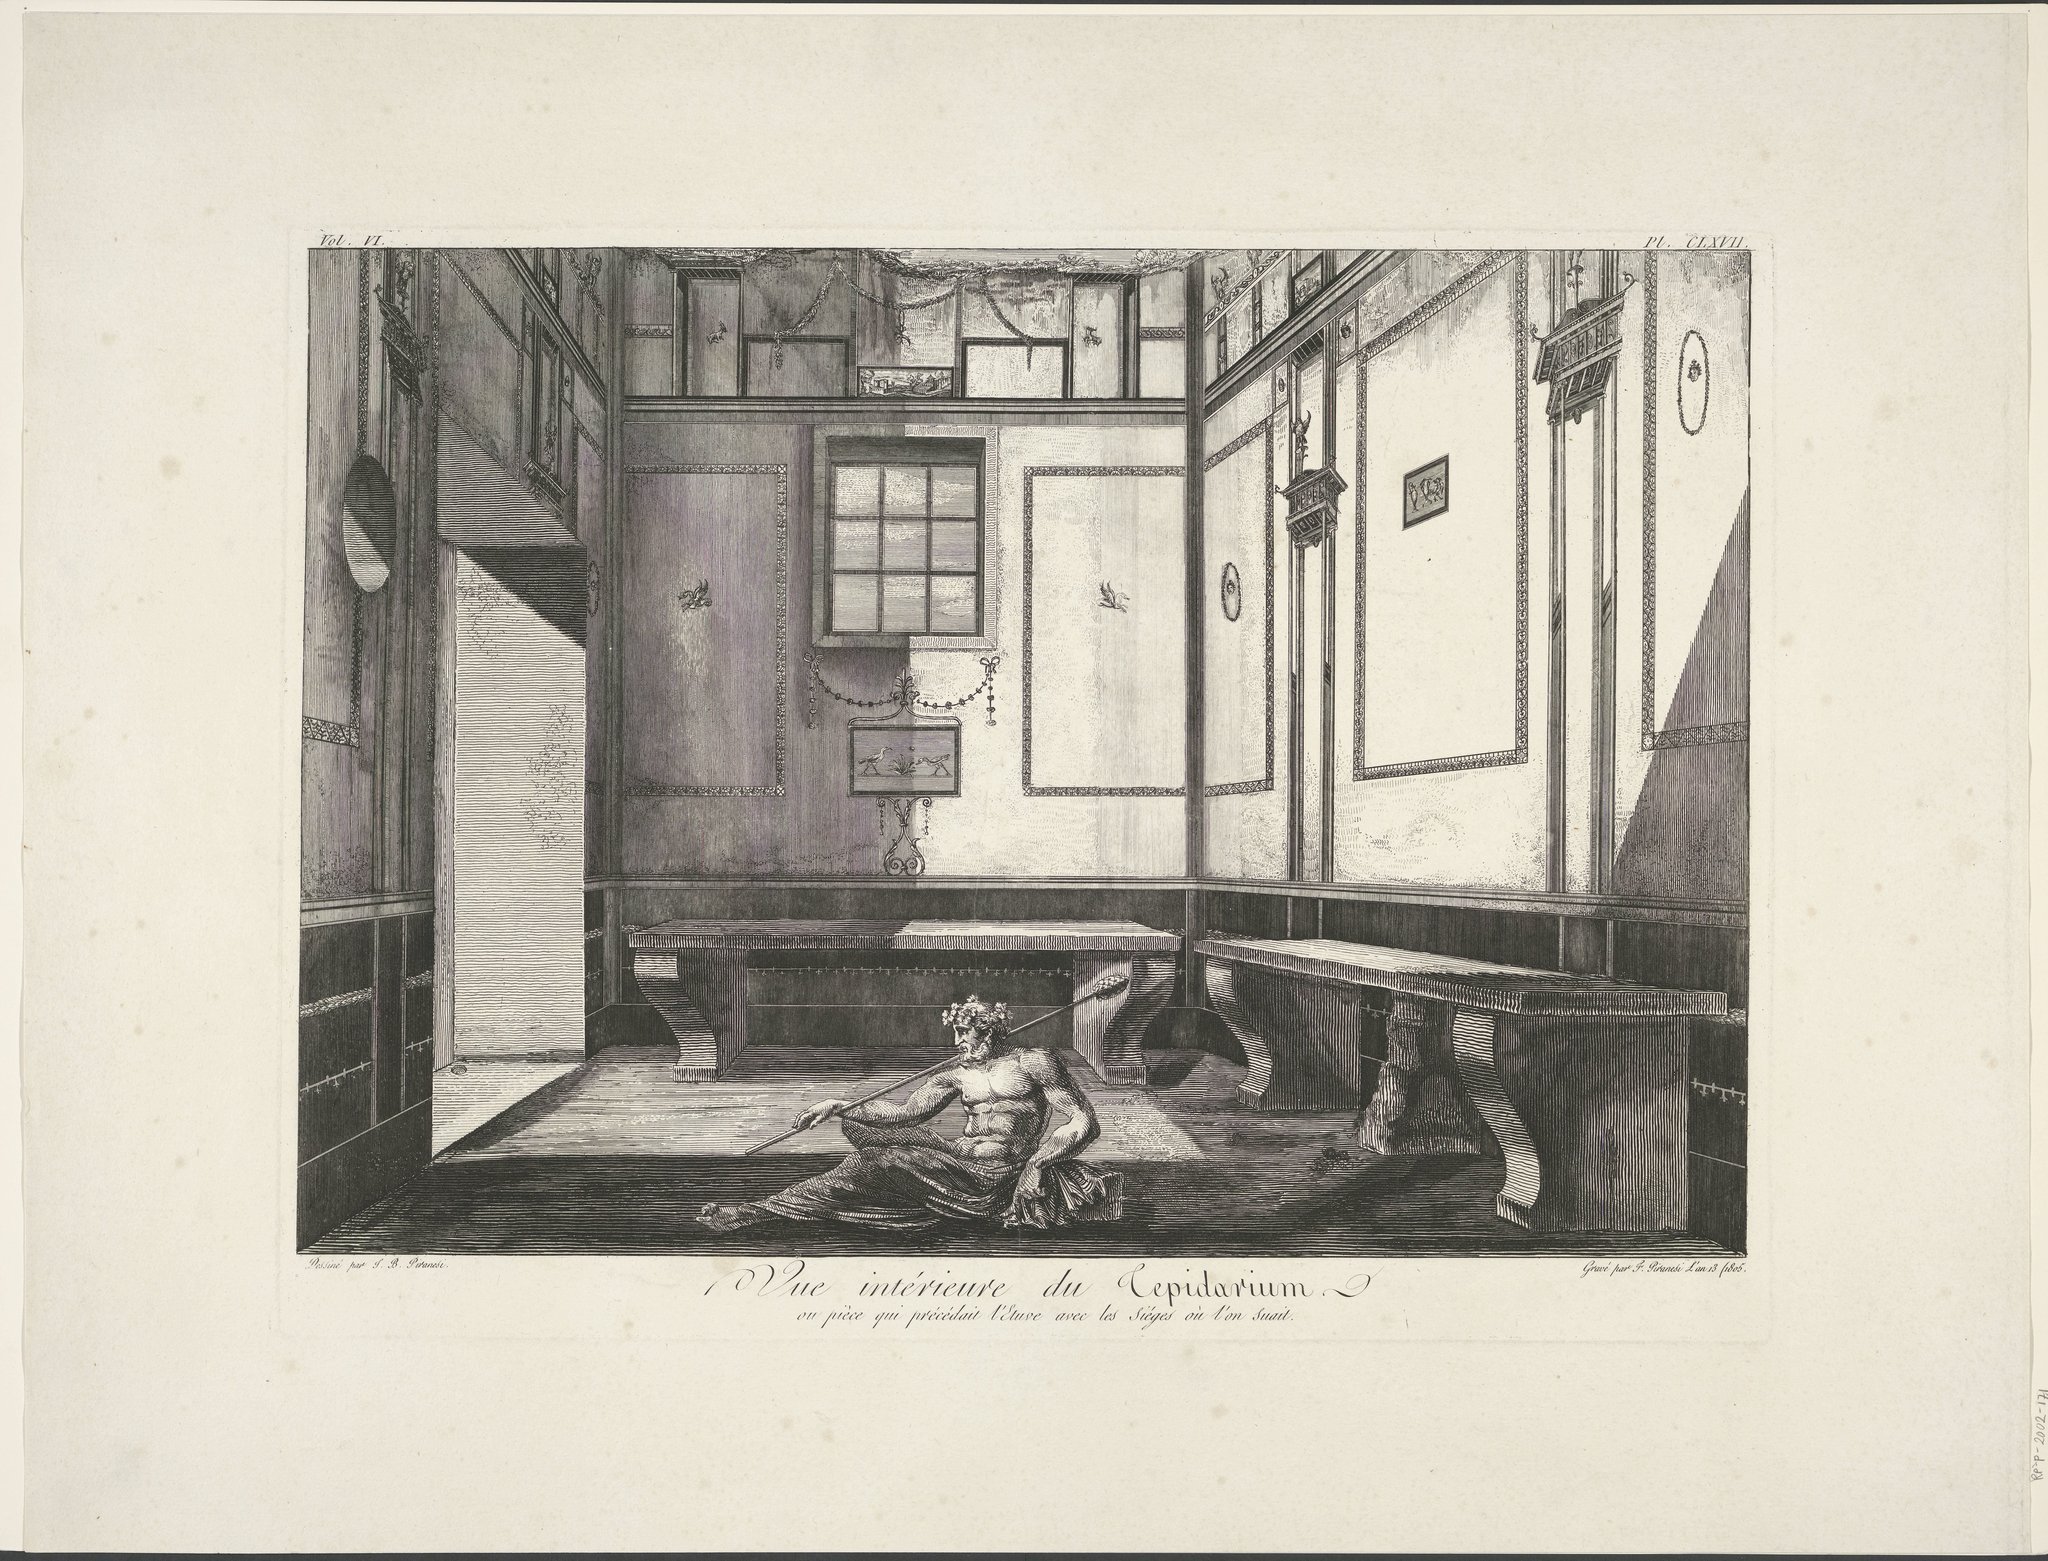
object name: print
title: Trepidarium in Pompeï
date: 1805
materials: paper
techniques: etching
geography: italy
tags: public baths, pompeii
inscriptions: collector's mark: Lugt 2228, collector's mark: Lugt 2760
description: Gezicht in een trepidarium, een warme centrale ruimte in een thermen, in Pompeï. Onderschrift in het Italiaans in ondermarge. Genummerd linksboven: Vol. VI., rechtsboven: Pl. CLXVII.